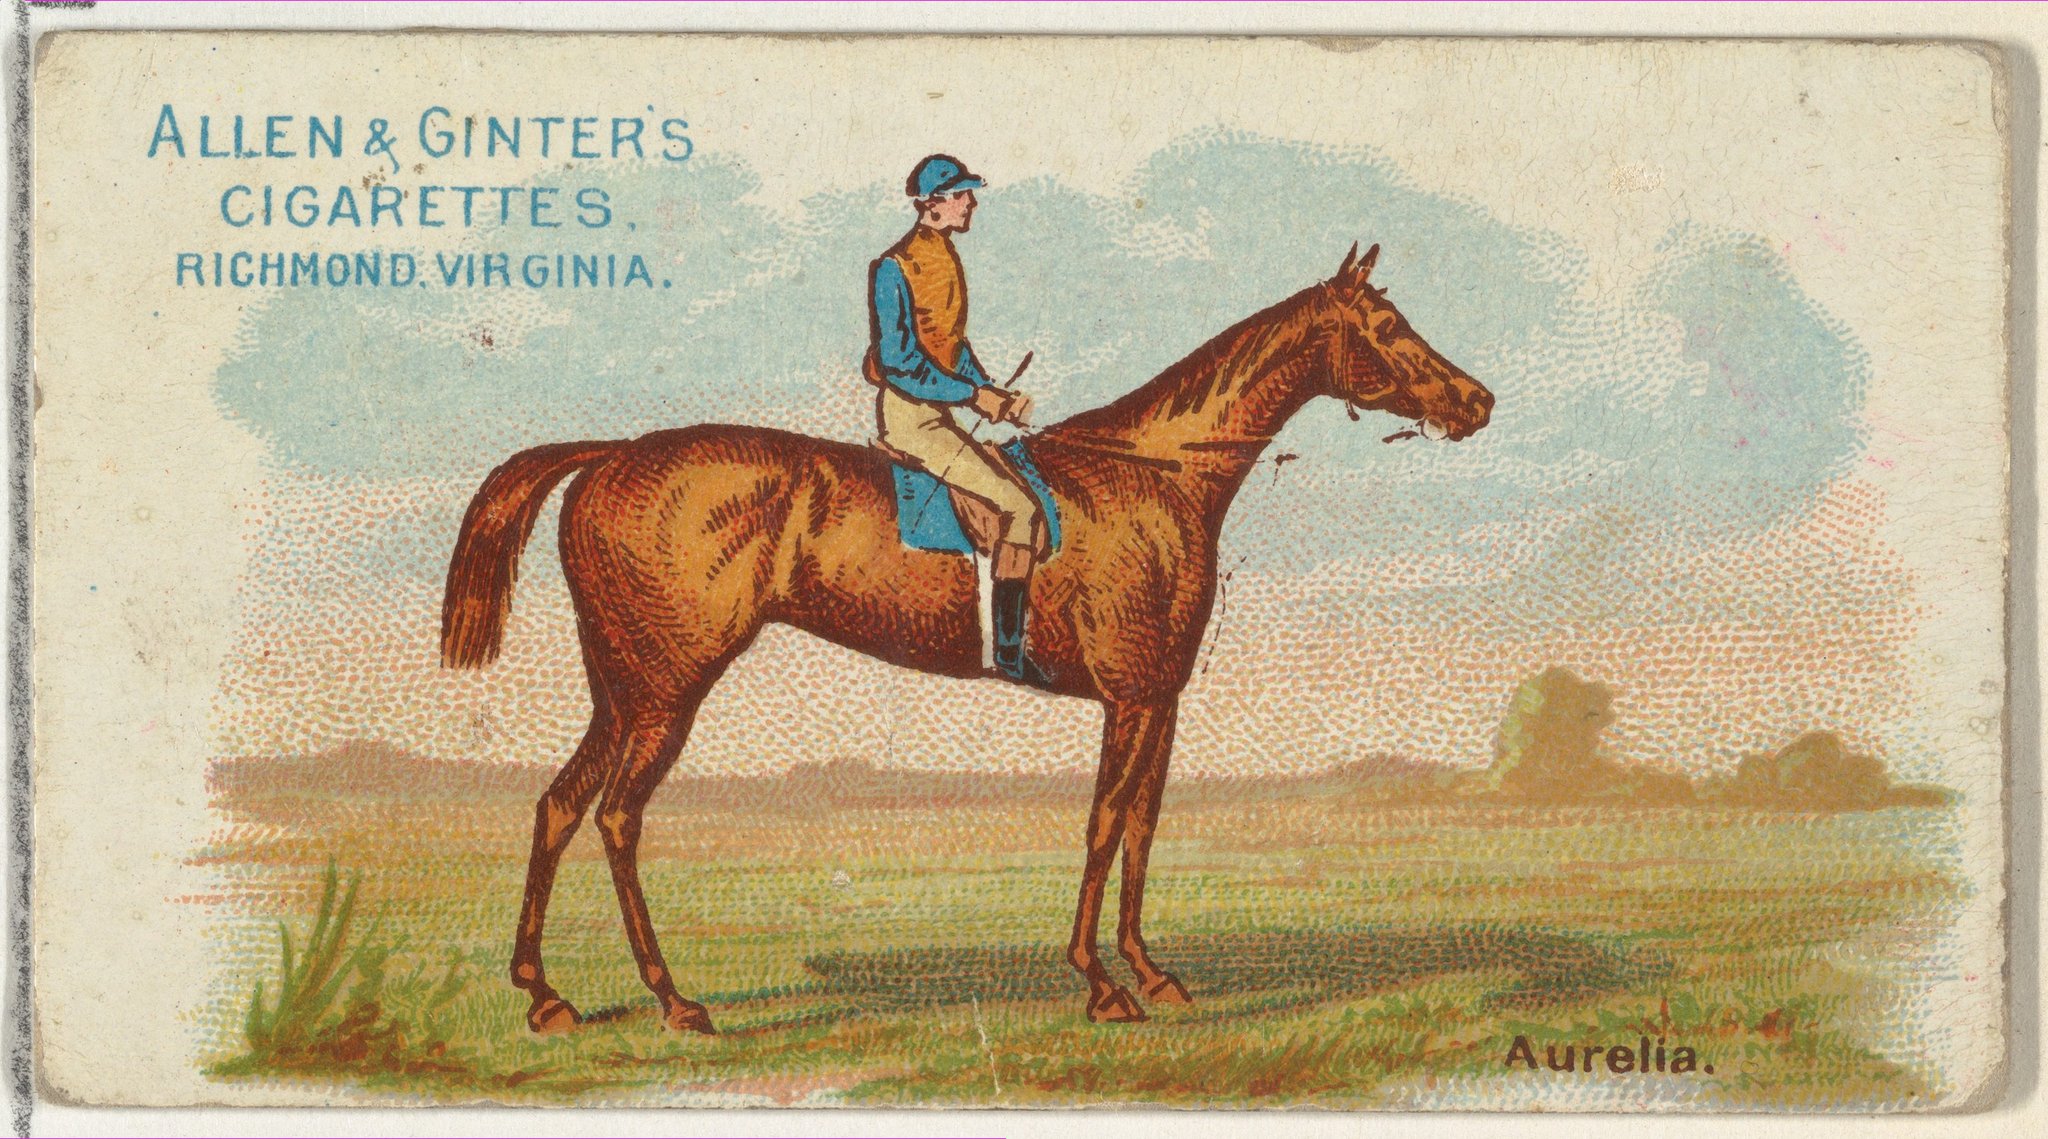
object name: print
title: Aurelia, from The World's Racers series (N32) for Allen & Ginter Cigarettes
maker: allen & ginter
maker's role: publisher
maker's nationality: american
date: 1888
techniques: color lithograph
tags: men,horses,jockeys